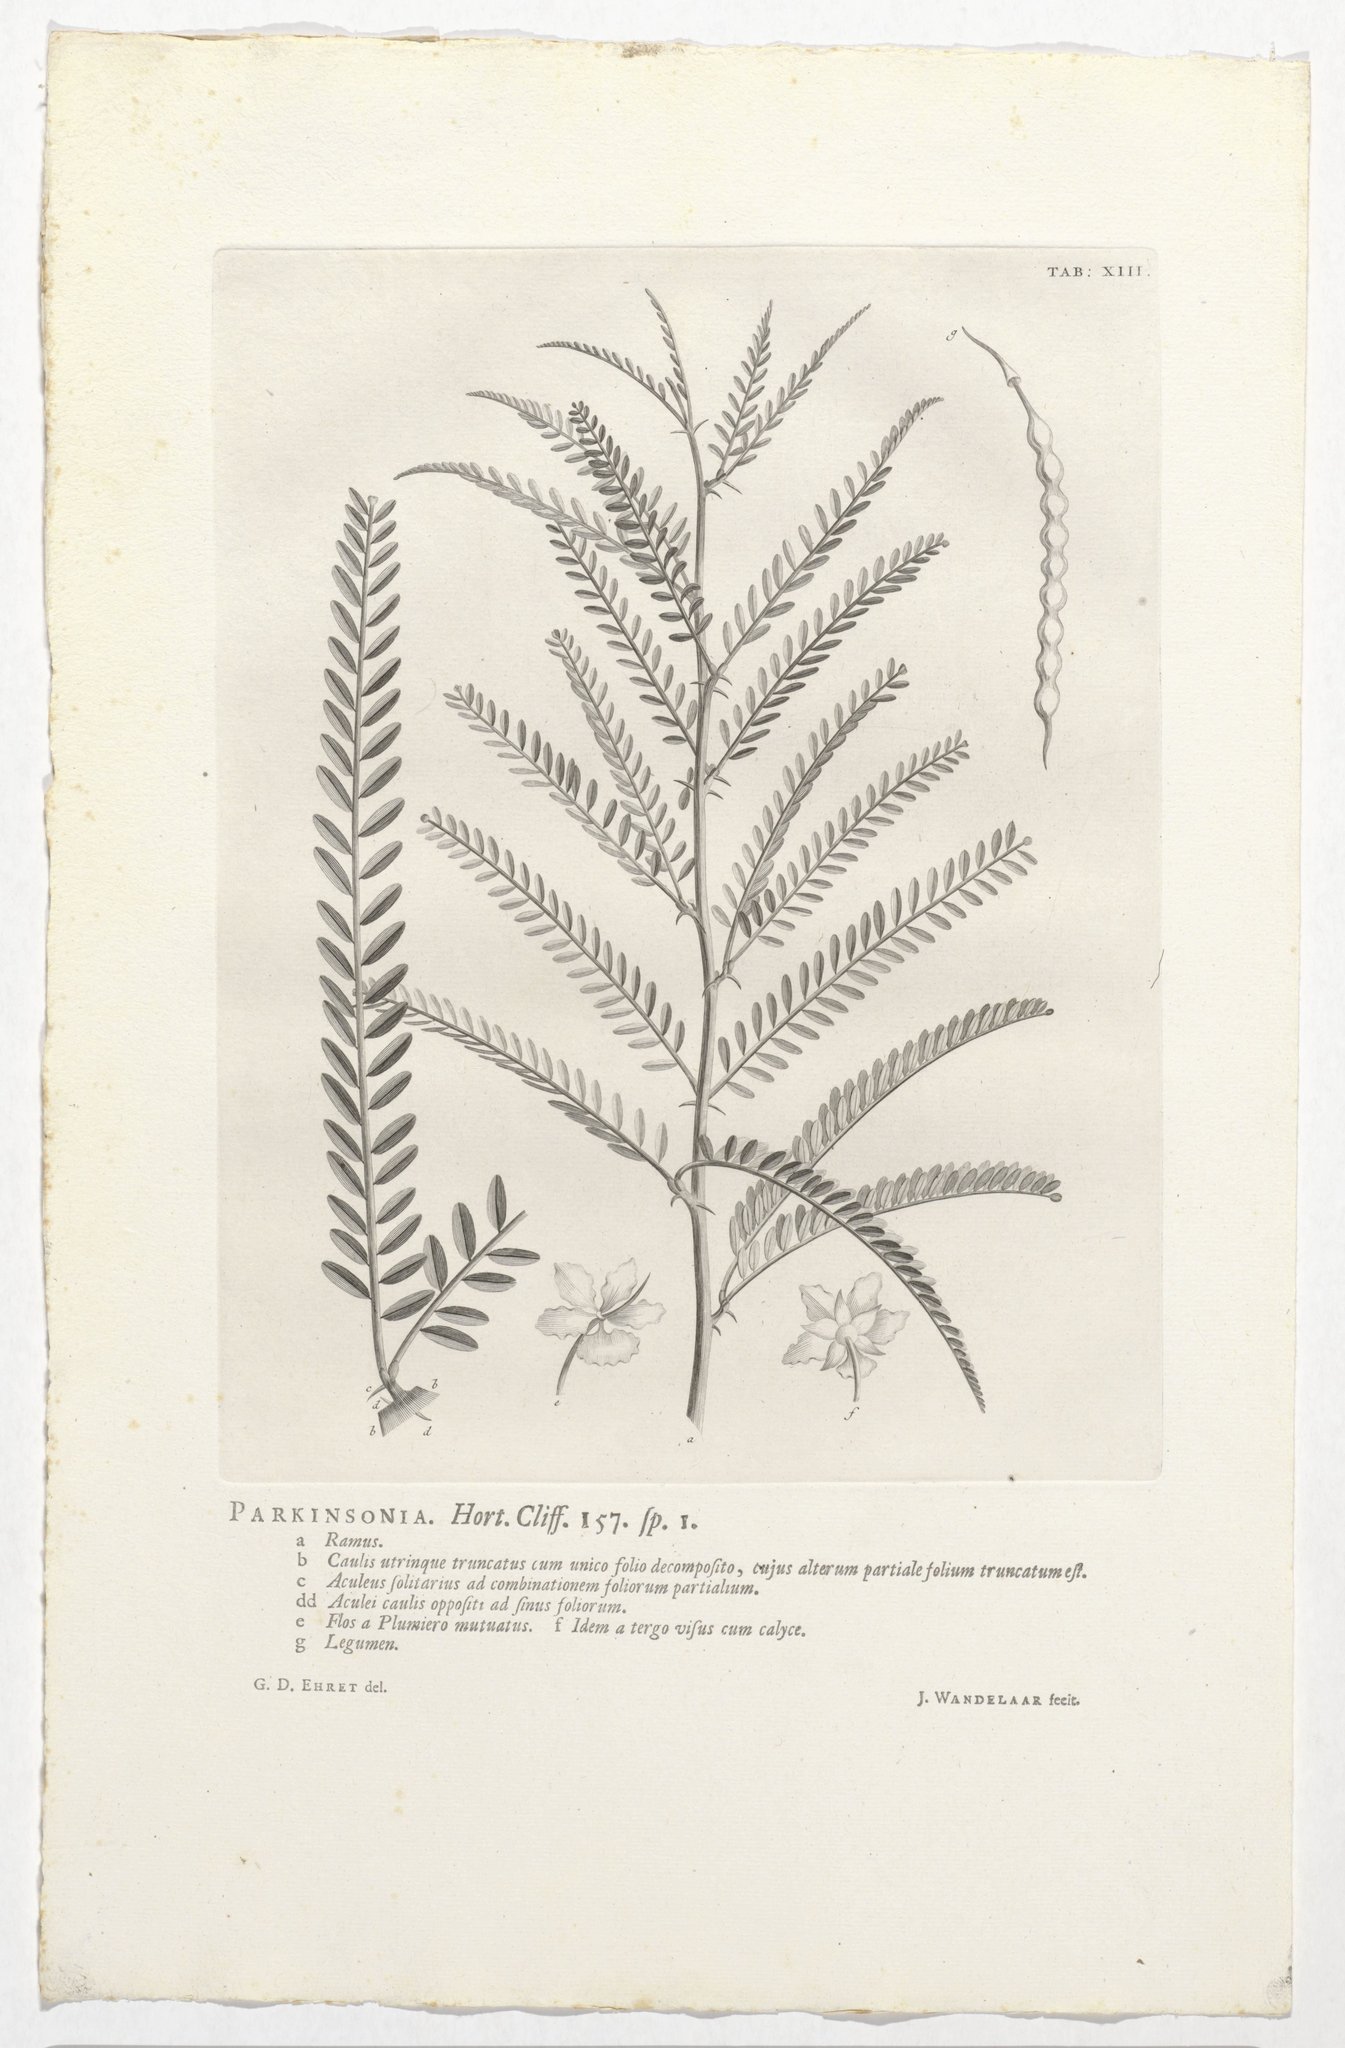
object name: print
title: Parkinsonia aculeata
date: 1738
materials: paper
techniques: etching, letterpress printing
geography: warmond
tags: flowers, plants and herbs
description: Prent gebruikt als illustratie in: Linnaeus, Carolus. Hortus Cliffortianus plantas exhibens quas in hortis tam vivis quam siccis, Hartecampi in Hollandia, coluit (...) Georgius Clifford. Amsterdam: sine nomen, 1738.